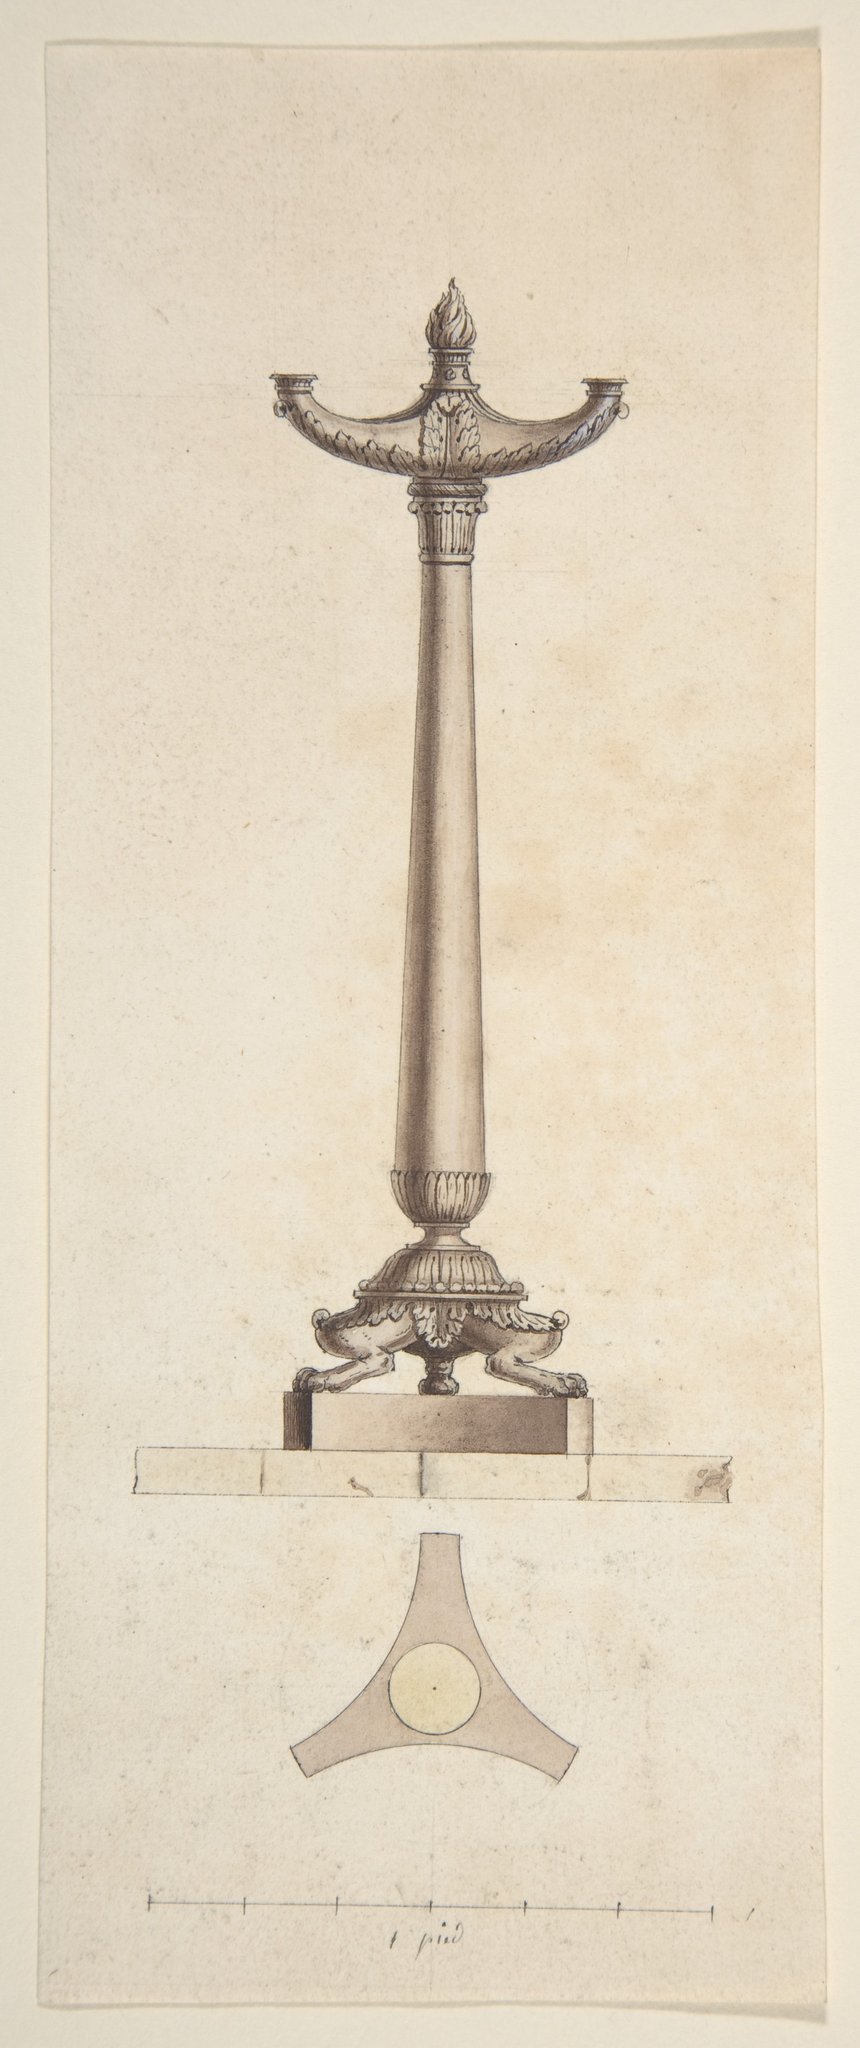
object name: drawing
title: Design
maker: anonymous, french, 19th century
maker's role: artist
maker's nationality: french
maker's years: 1800-1900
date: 1801-1900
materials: gouache, ink, watercolor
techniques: pen